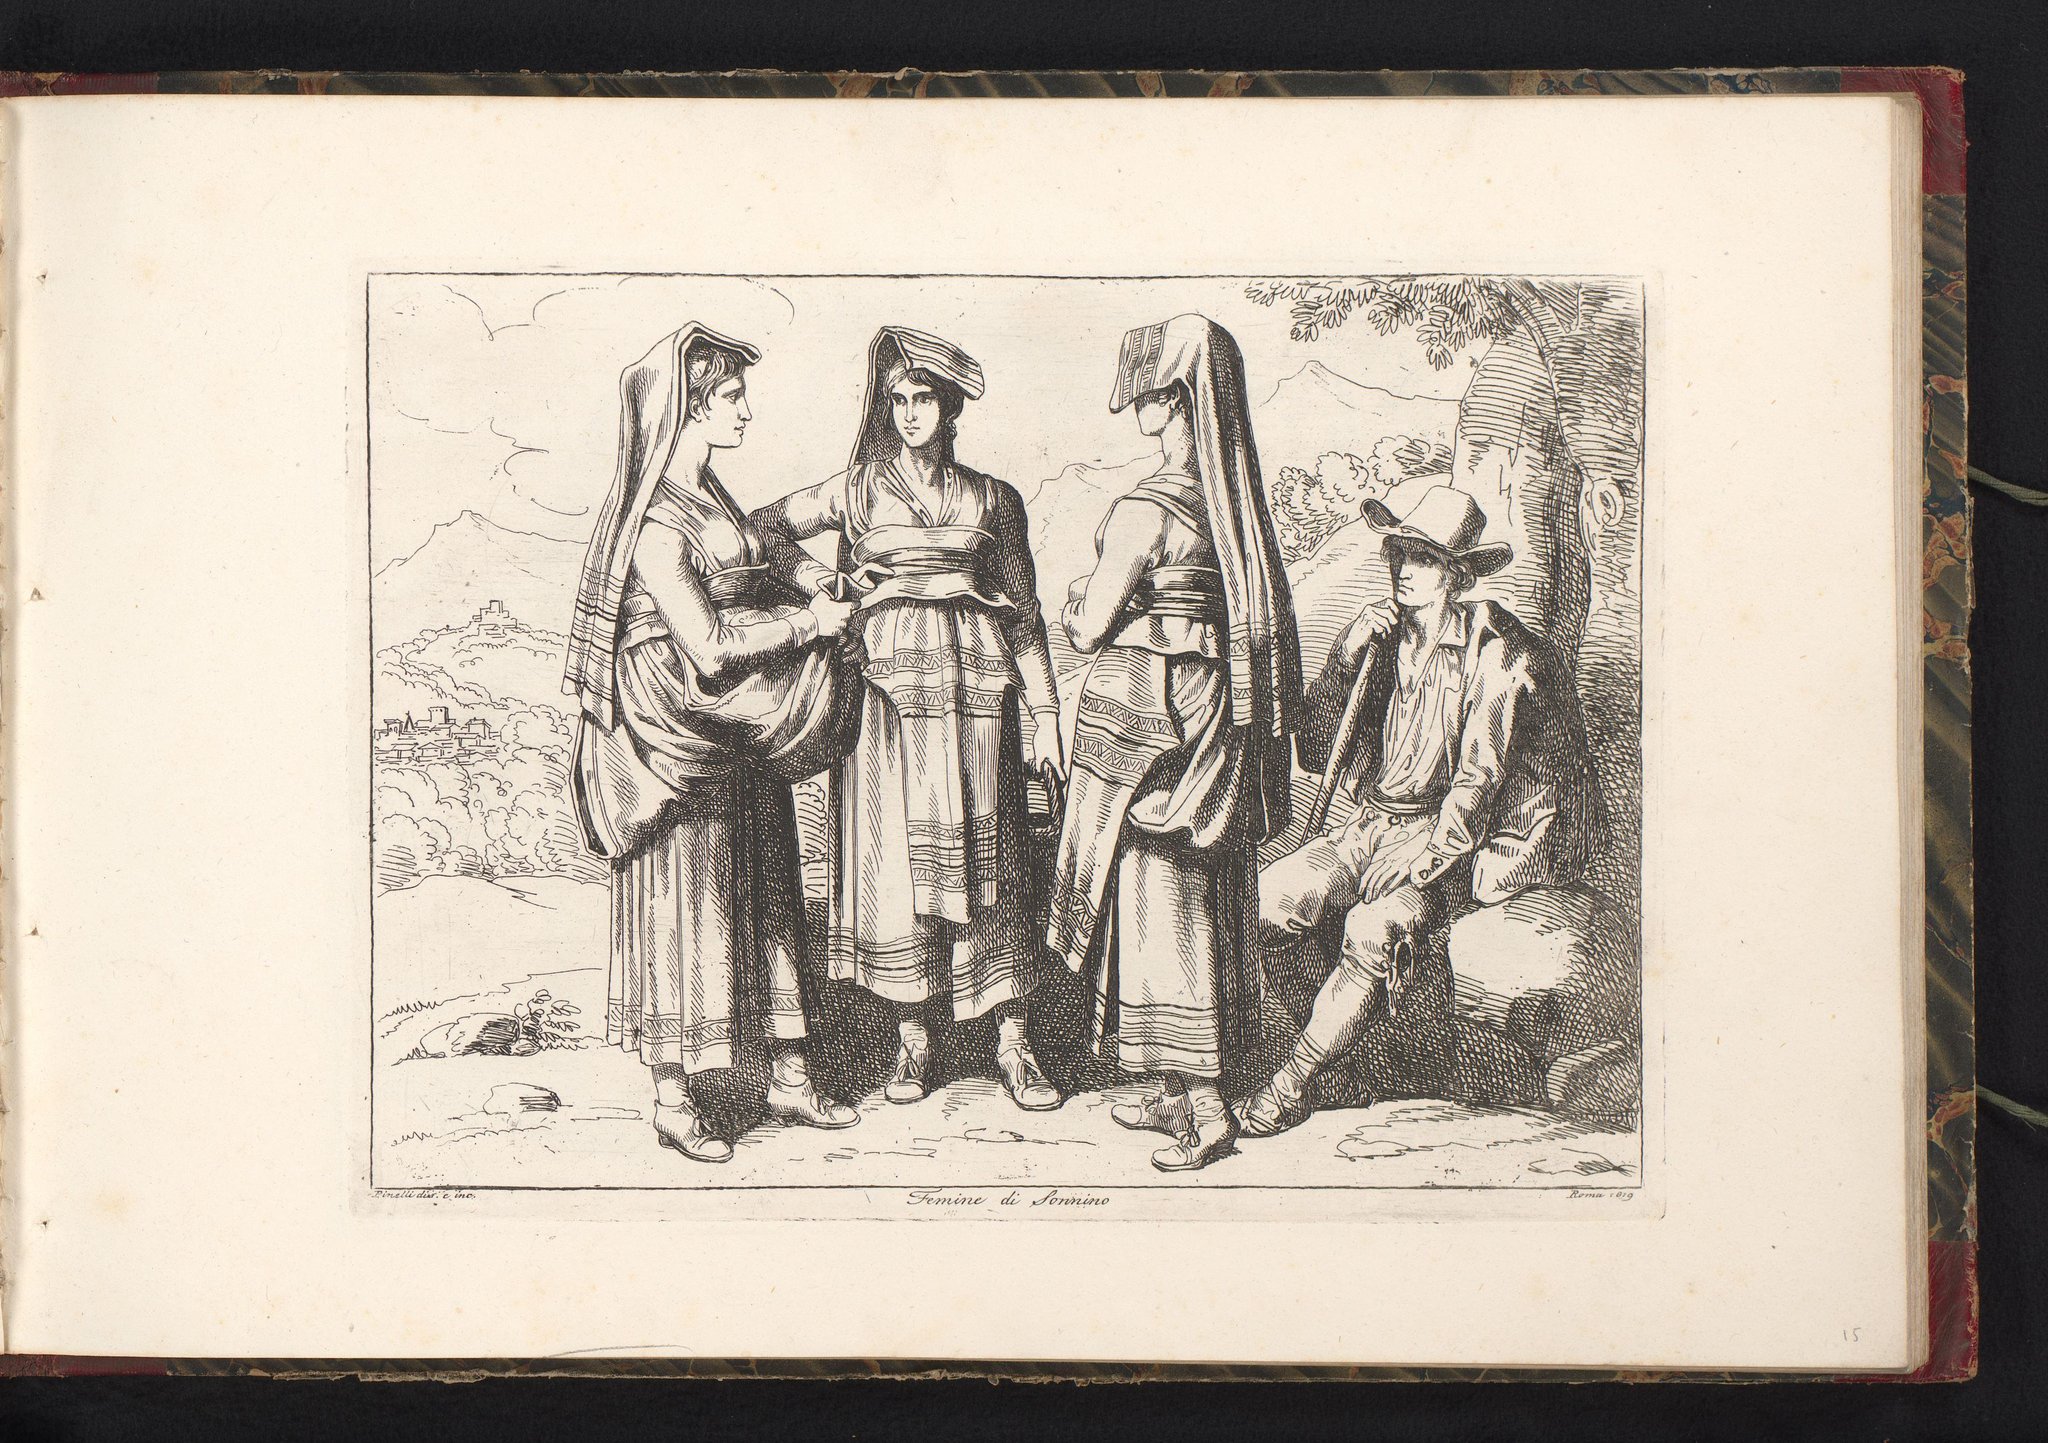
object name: print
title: Kostuumprenten met figuren uit Rome en omgeving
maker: bartolomeo pinelli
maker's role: draughtsman, print maker, sculptor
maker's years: 1781-1835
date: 1819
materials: paper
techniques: etching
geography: rome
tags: city-view, and landscape with man-made constructions, herding, herdsman, herdswoman, shepherd, shepherdess, cowherd, etc., head-gear: hat, folk costume, regional costume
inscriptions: date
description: Deze prent maakt deel uit van een serie van 50 prenten. De serie bestaat uit kostuumprenten en voorstellingen van bandieten.